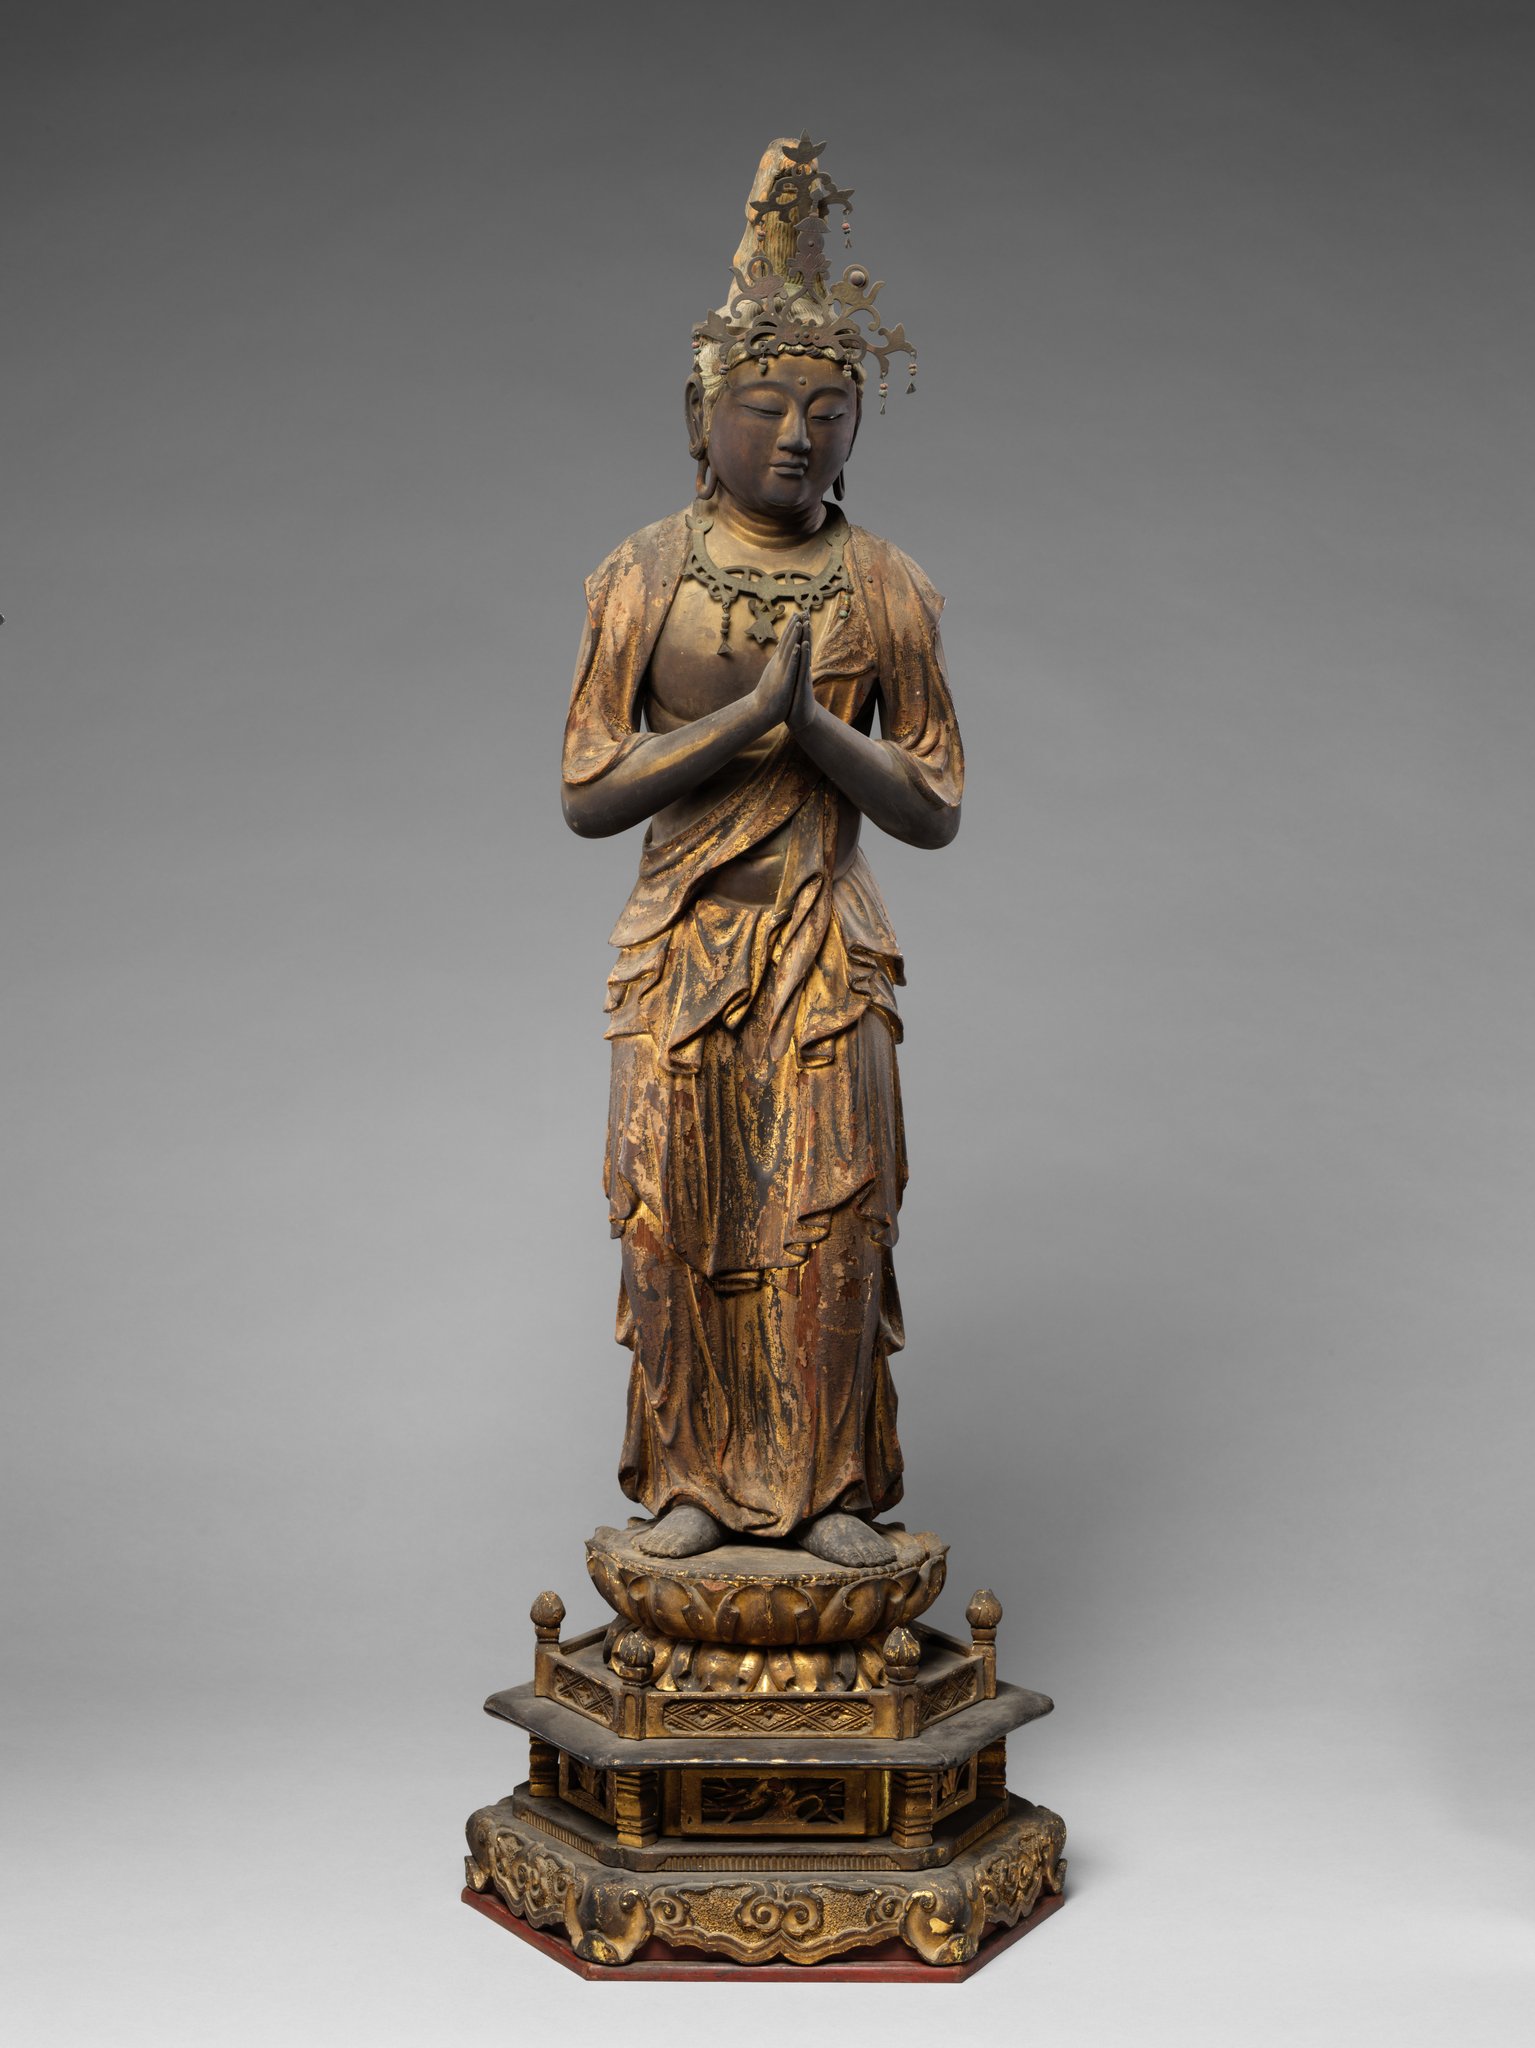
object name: statuette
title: Attendant Bodhisattva Seishi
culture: japanese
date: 1167-1300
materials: crystal, gold leaf, gold paint, lacquer, wood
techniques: inlay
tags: buddhism,bodhisattvas,buddha